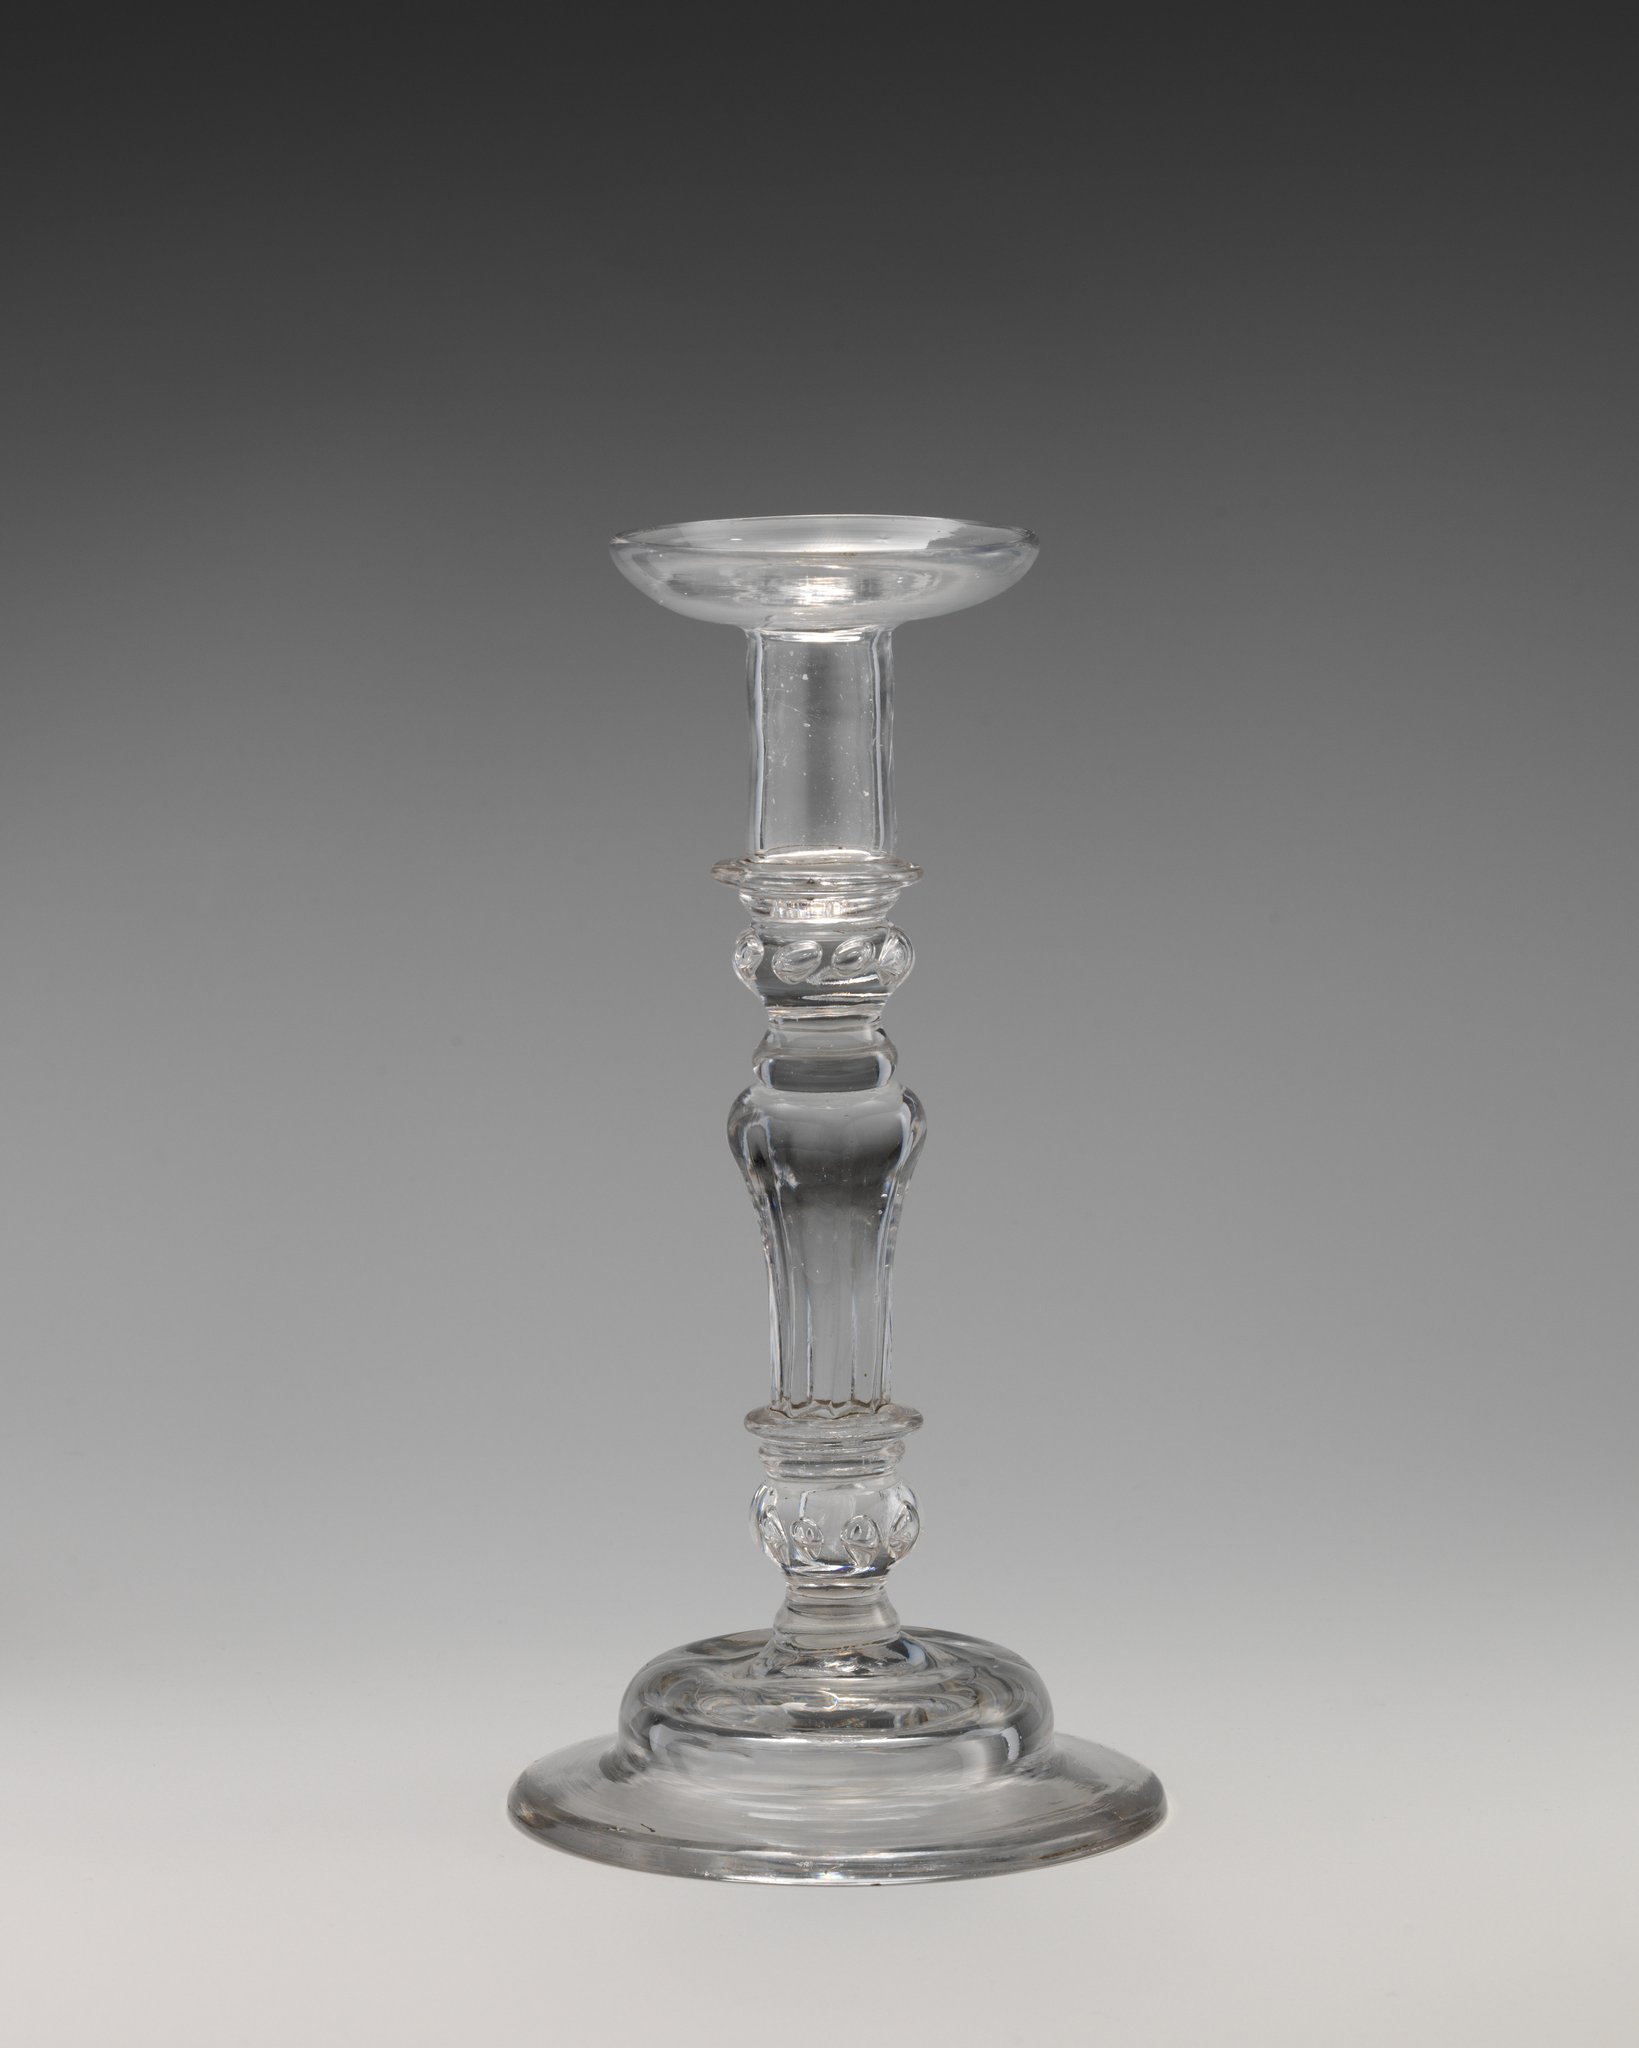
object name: taperstick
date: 1740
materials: glass